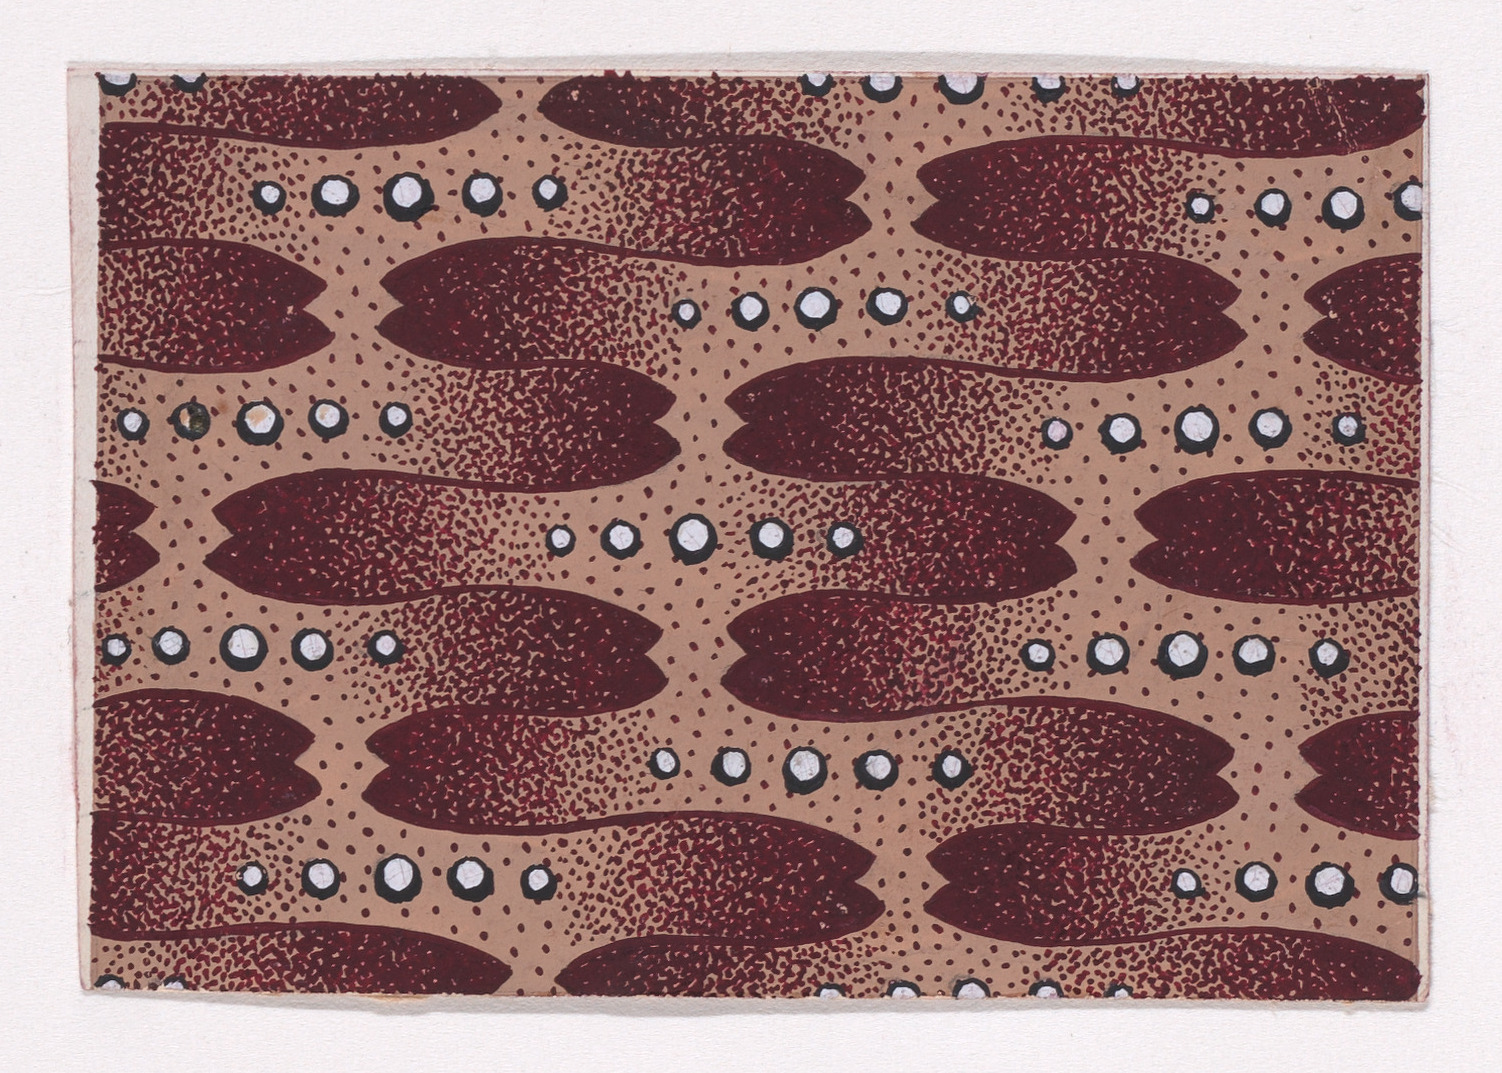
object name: drawing ornament architecture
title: Textile Design with Alternating Vertical Garlands of Abstract Shapes Adorned with Pearls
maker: anonymous, alsatian, 19th century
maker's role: artist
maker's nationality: alsatian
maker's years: 1800-1900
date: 1840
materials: gouache